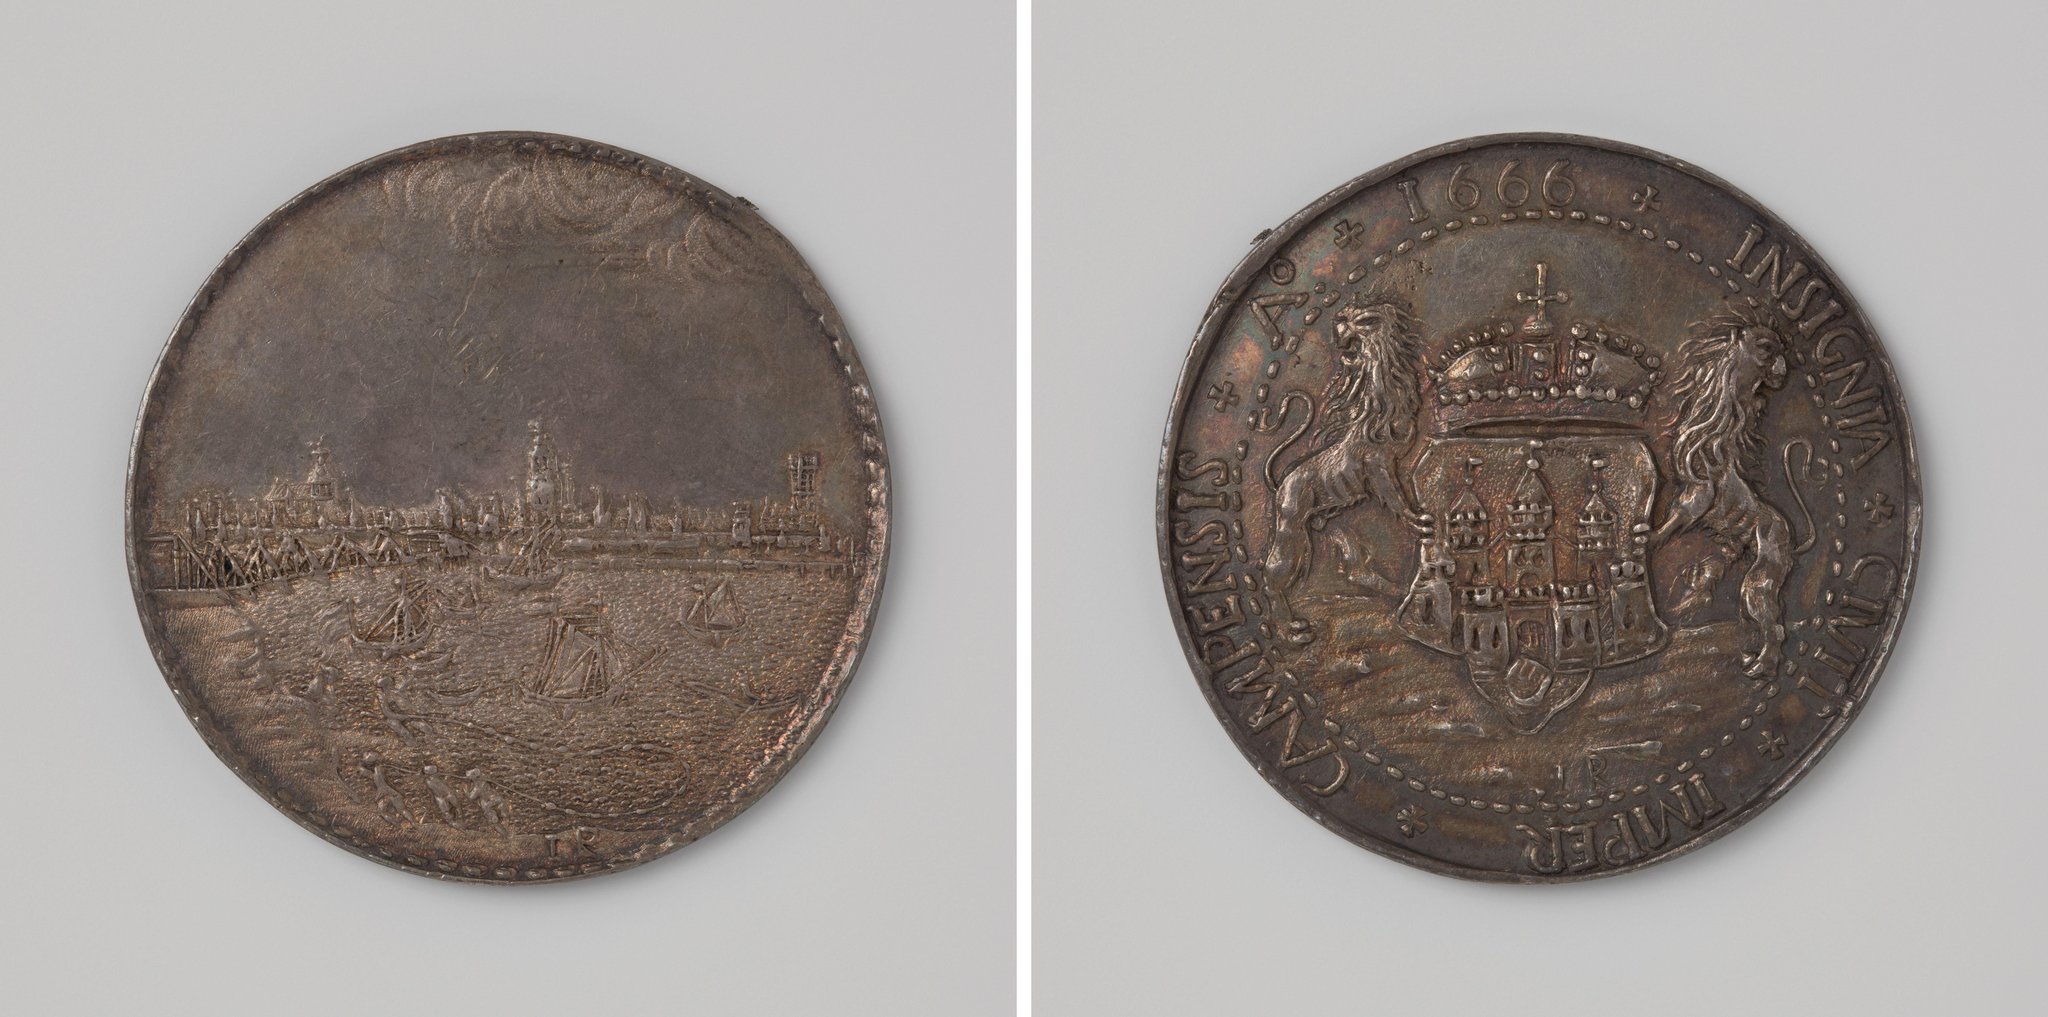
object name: history medal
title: Openen van de geldbussen te Kampen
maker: jacob ridder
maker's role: medailleur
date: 1666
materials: silver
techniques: striking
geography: kampen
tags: kampen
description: Zilveren penning. Voorzijde: gezicht op stad Kampen aan haven. Keerzijde: gekroond wapenschild geflankeerd door twee leeuwen binnen omschrift